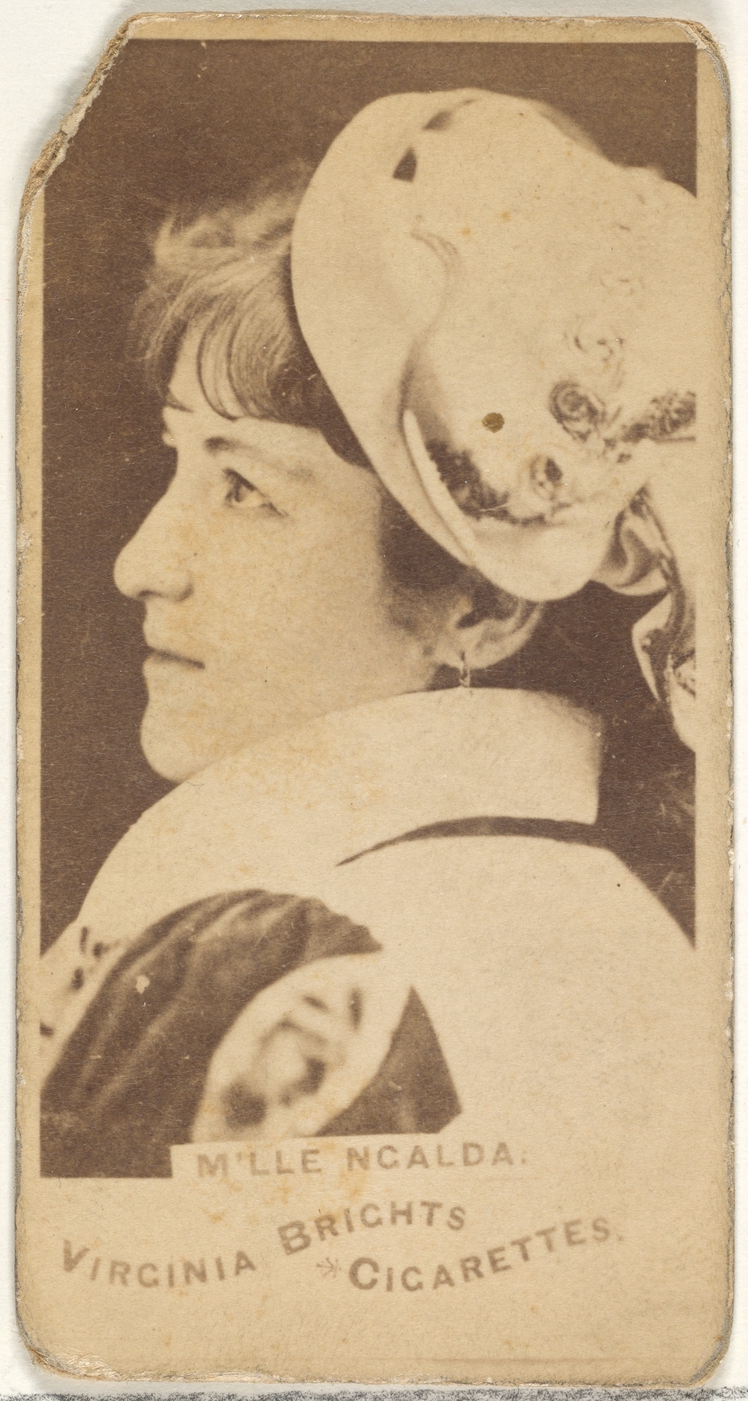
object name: photograph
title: M'lle Ncalda, from the Actors and Actresses series (N45, Type 1) for Virginia Brights Cigarettes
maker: allen & ginter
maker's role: publisher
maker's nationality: american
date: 1888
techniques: albumen silver print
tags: portraits,women,actresses